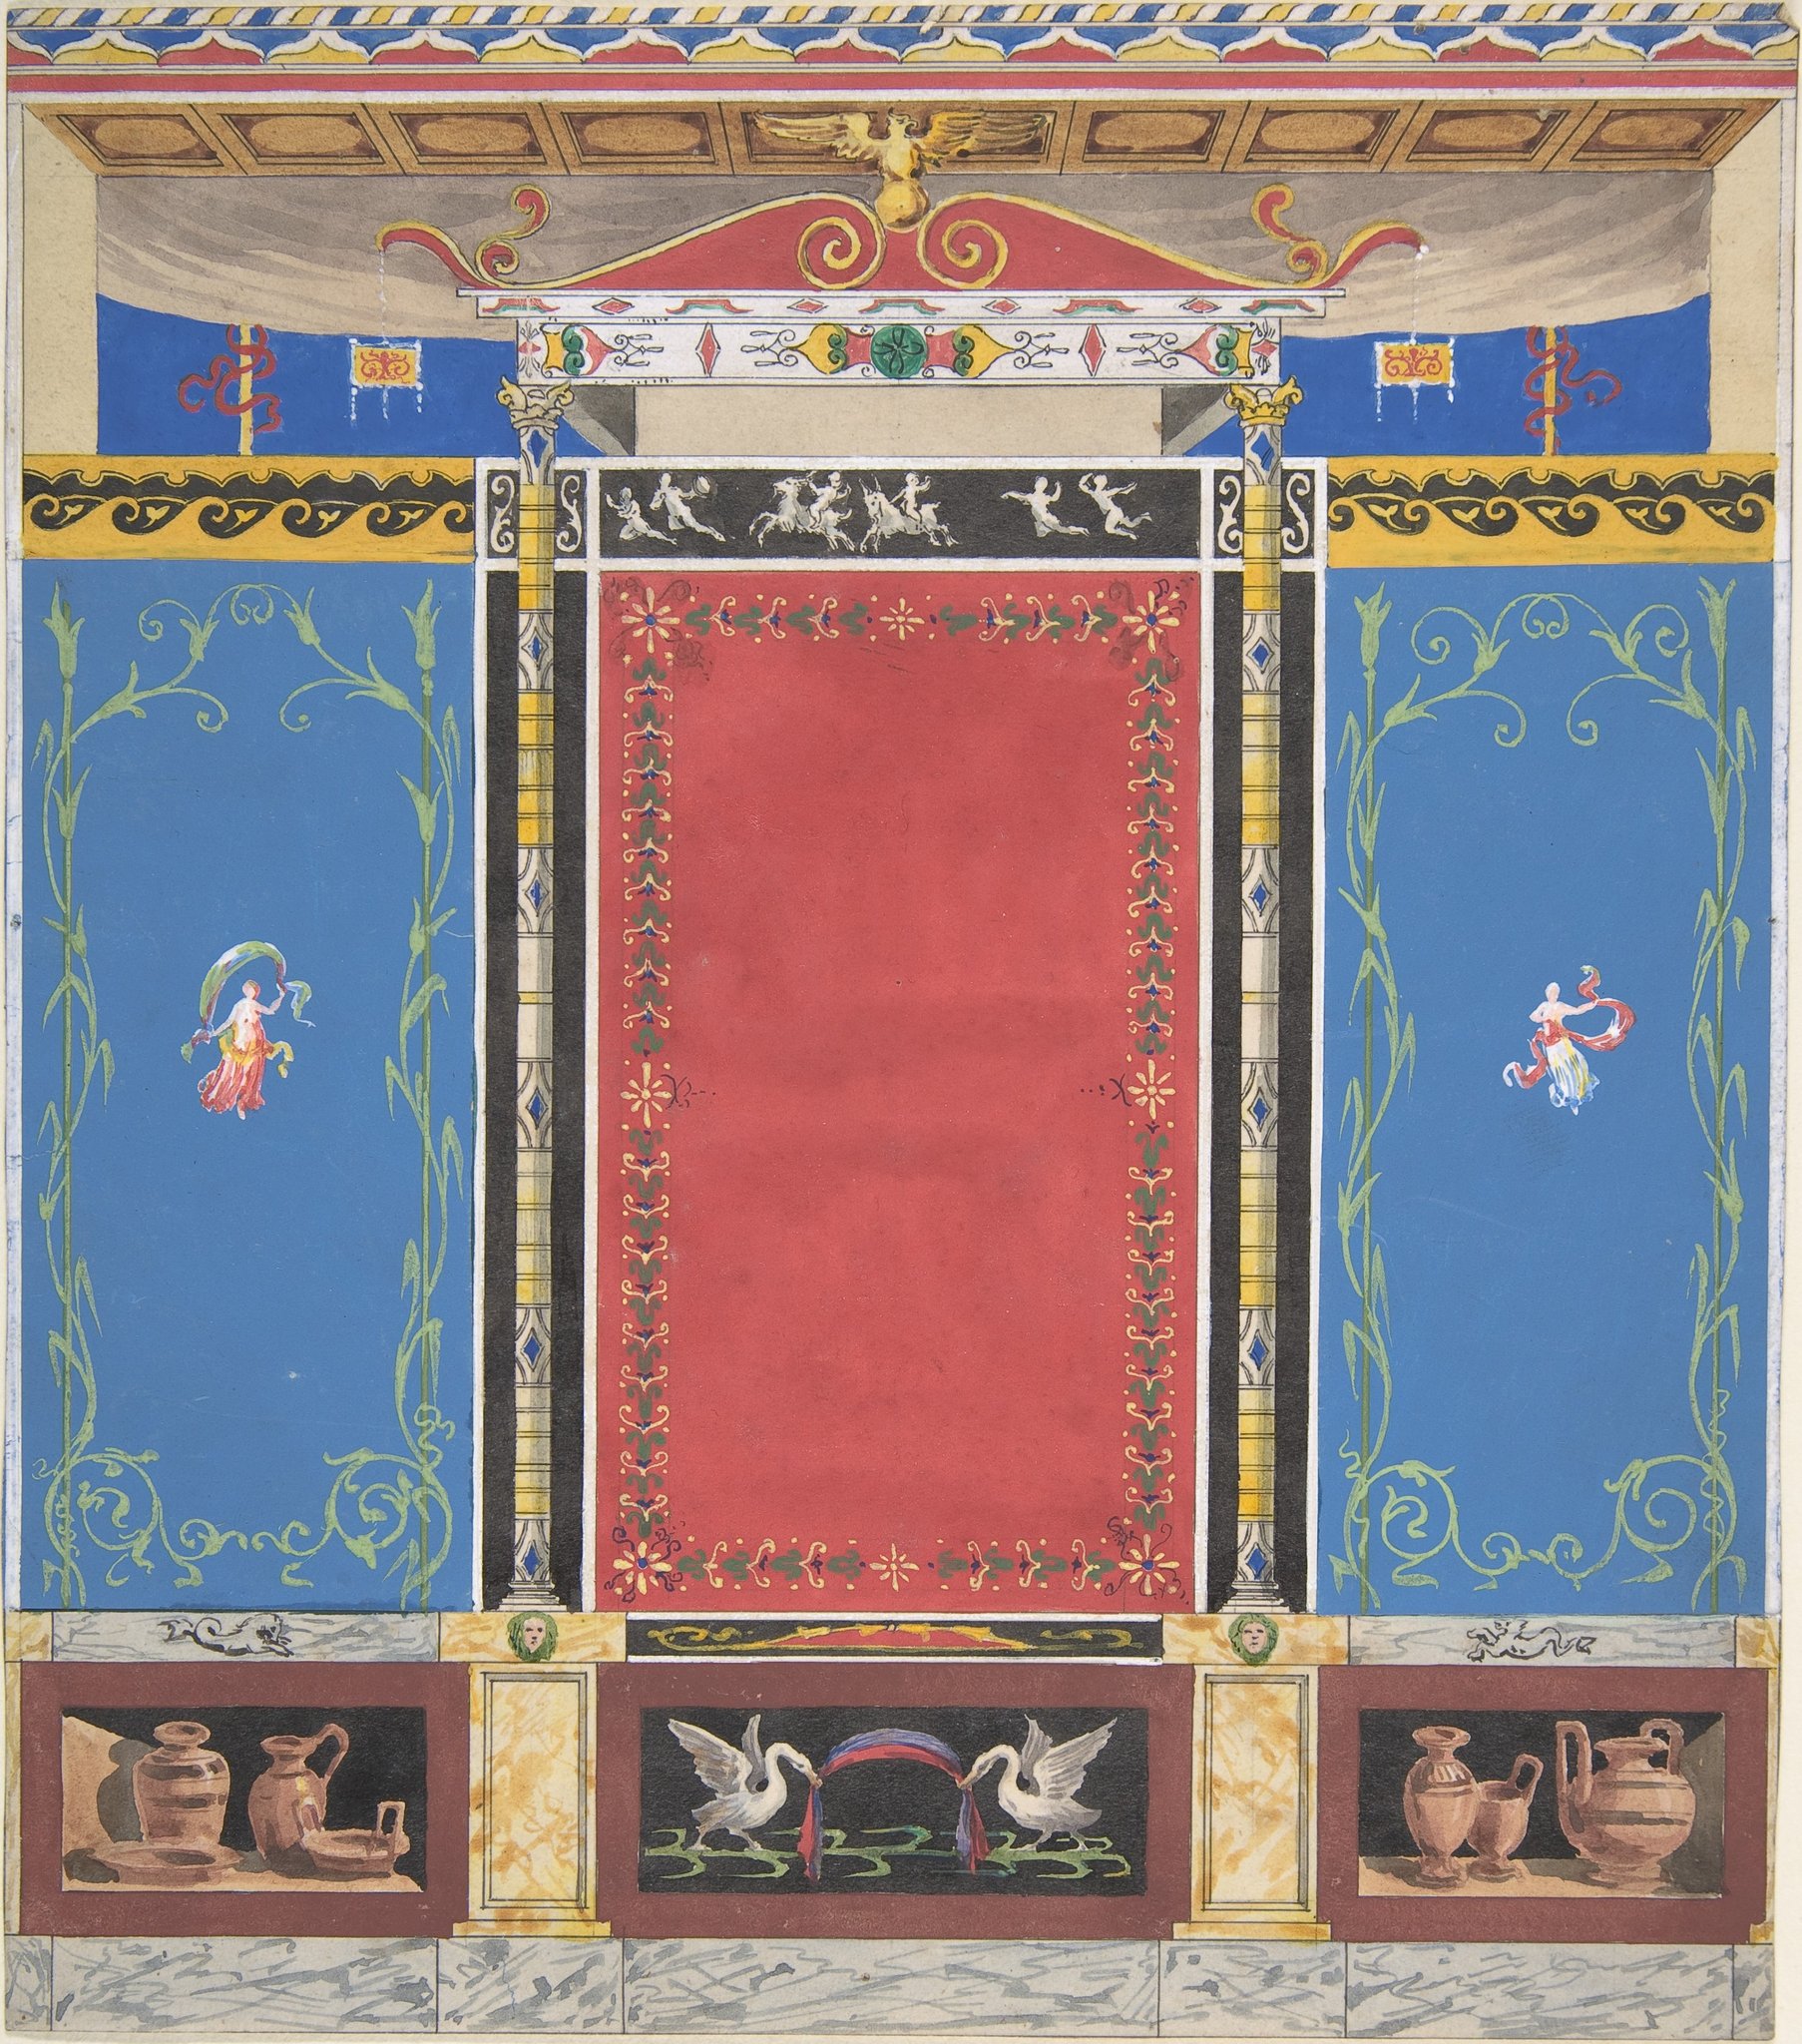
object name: drawing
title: Painted Wall Decor Featuring Thin Column with a Pair of Swans and Trompe L'Oeil Vases at Base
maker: jules-edmond-charles lachaise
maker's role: artist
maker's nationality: french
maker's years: 1897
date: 1801-1900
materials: gouache, ink, watercolor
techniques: pen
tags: swans,vases